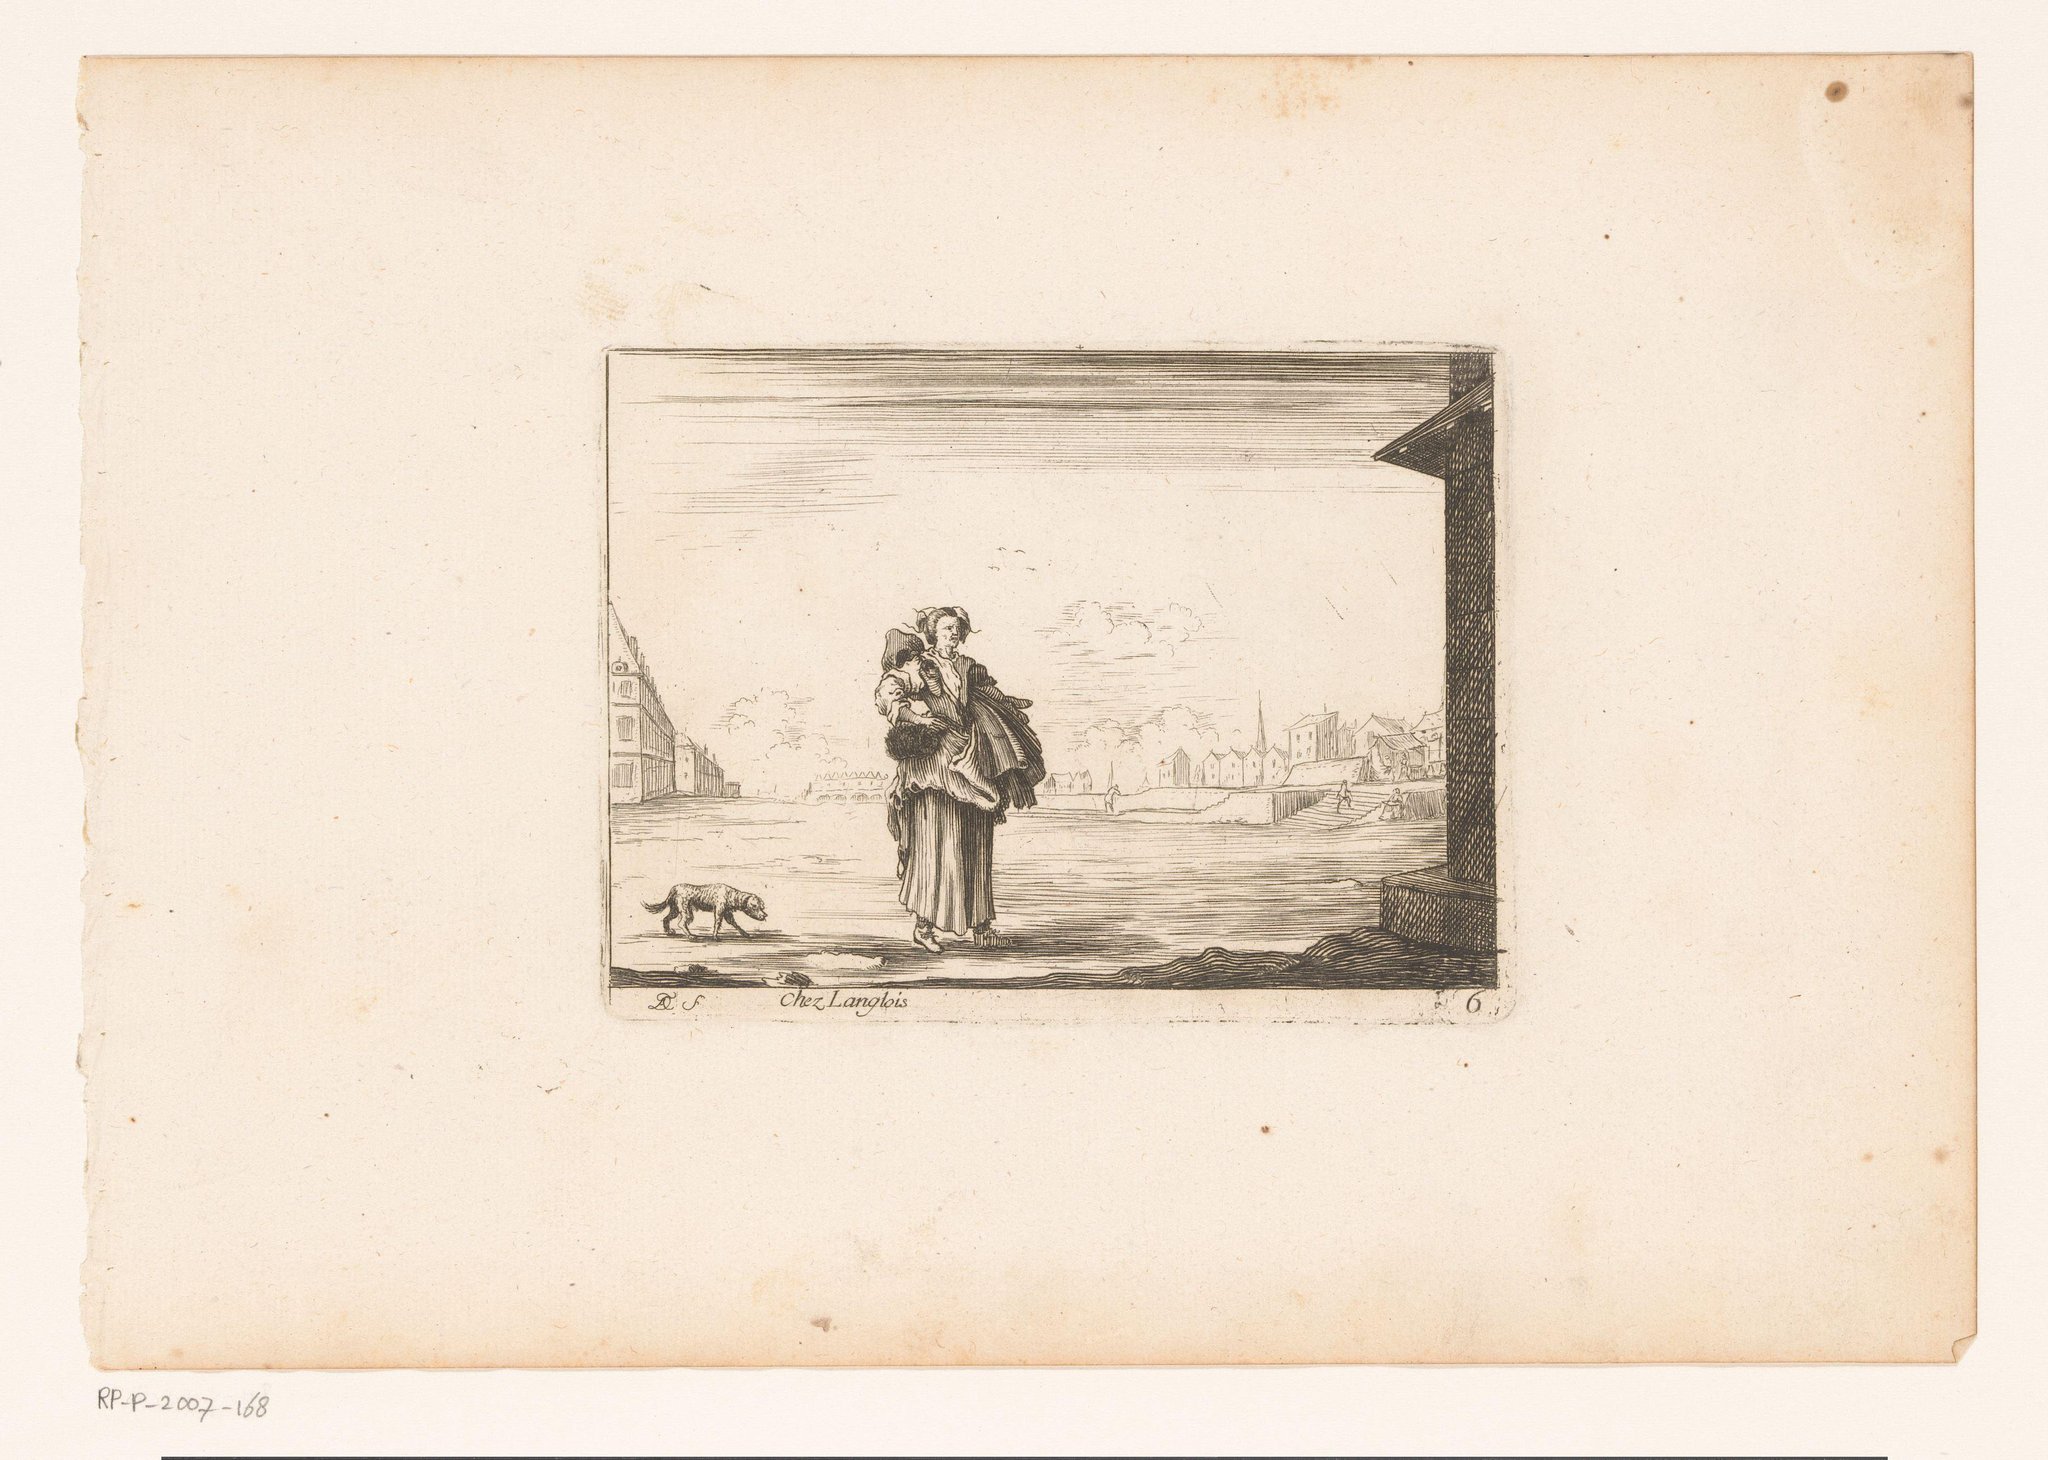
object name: print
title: Diverses figures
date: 1670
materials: paper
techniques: etching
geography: paris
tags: muff, street-trader - bb - women engaged in trade and commerce, dog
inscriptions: collector's mark: Lugt 2760, collector's mark: Lugt 2228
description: Maakt deel uit van een serie van twaalf prenten met verschillende figuren, uitgegeven door Langlois in Parijs.